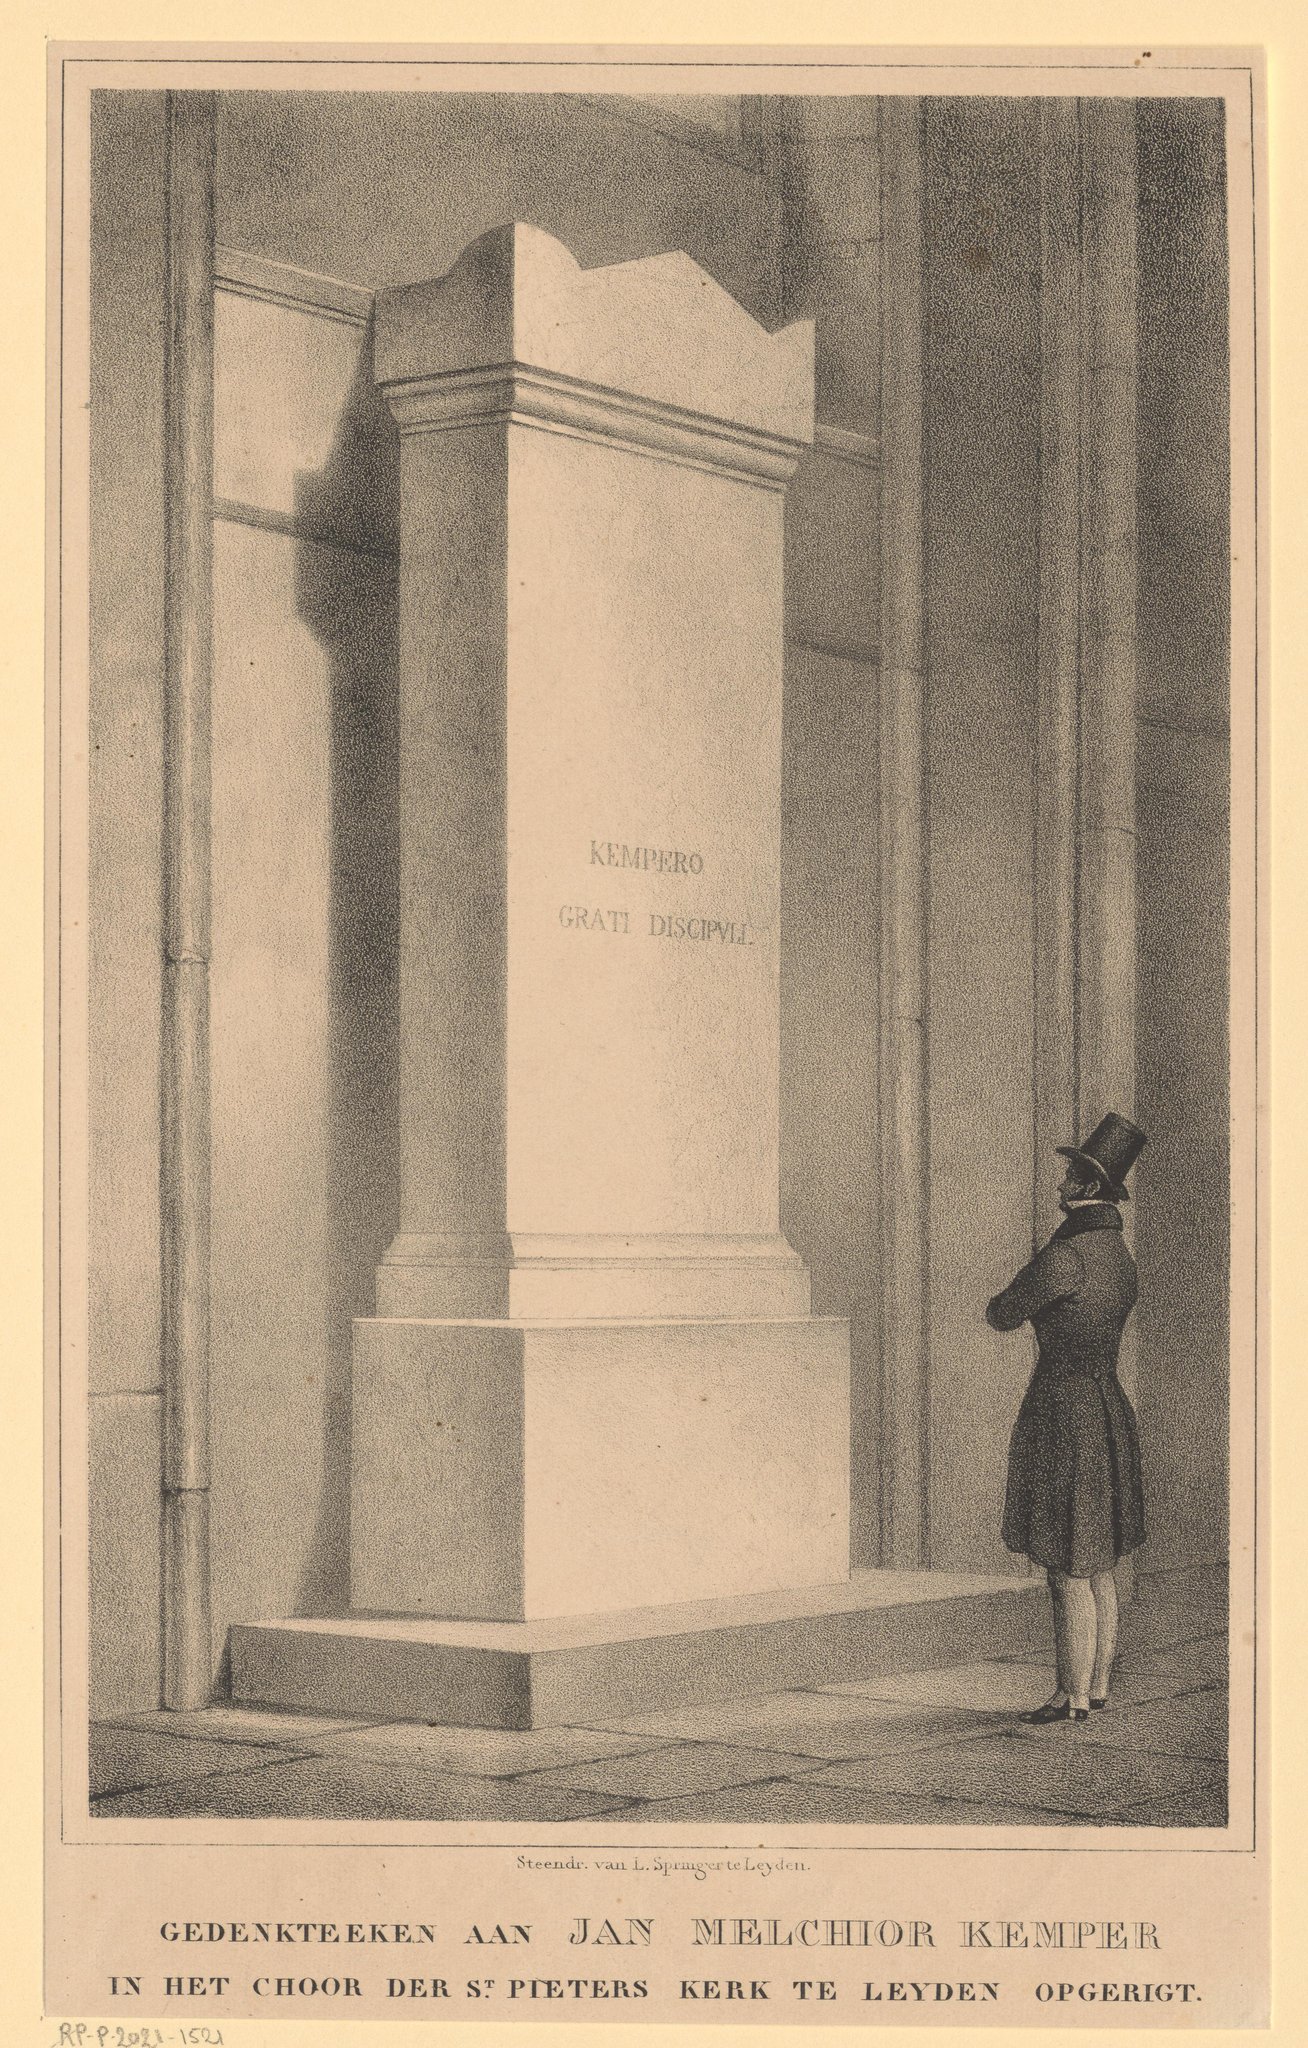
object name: print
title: Gedenkteken voor Joan Melchior de Bosch Kemper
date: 1835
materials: paper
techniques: lithograph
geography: leiden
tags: historical persons, grave-building, monumental tomb